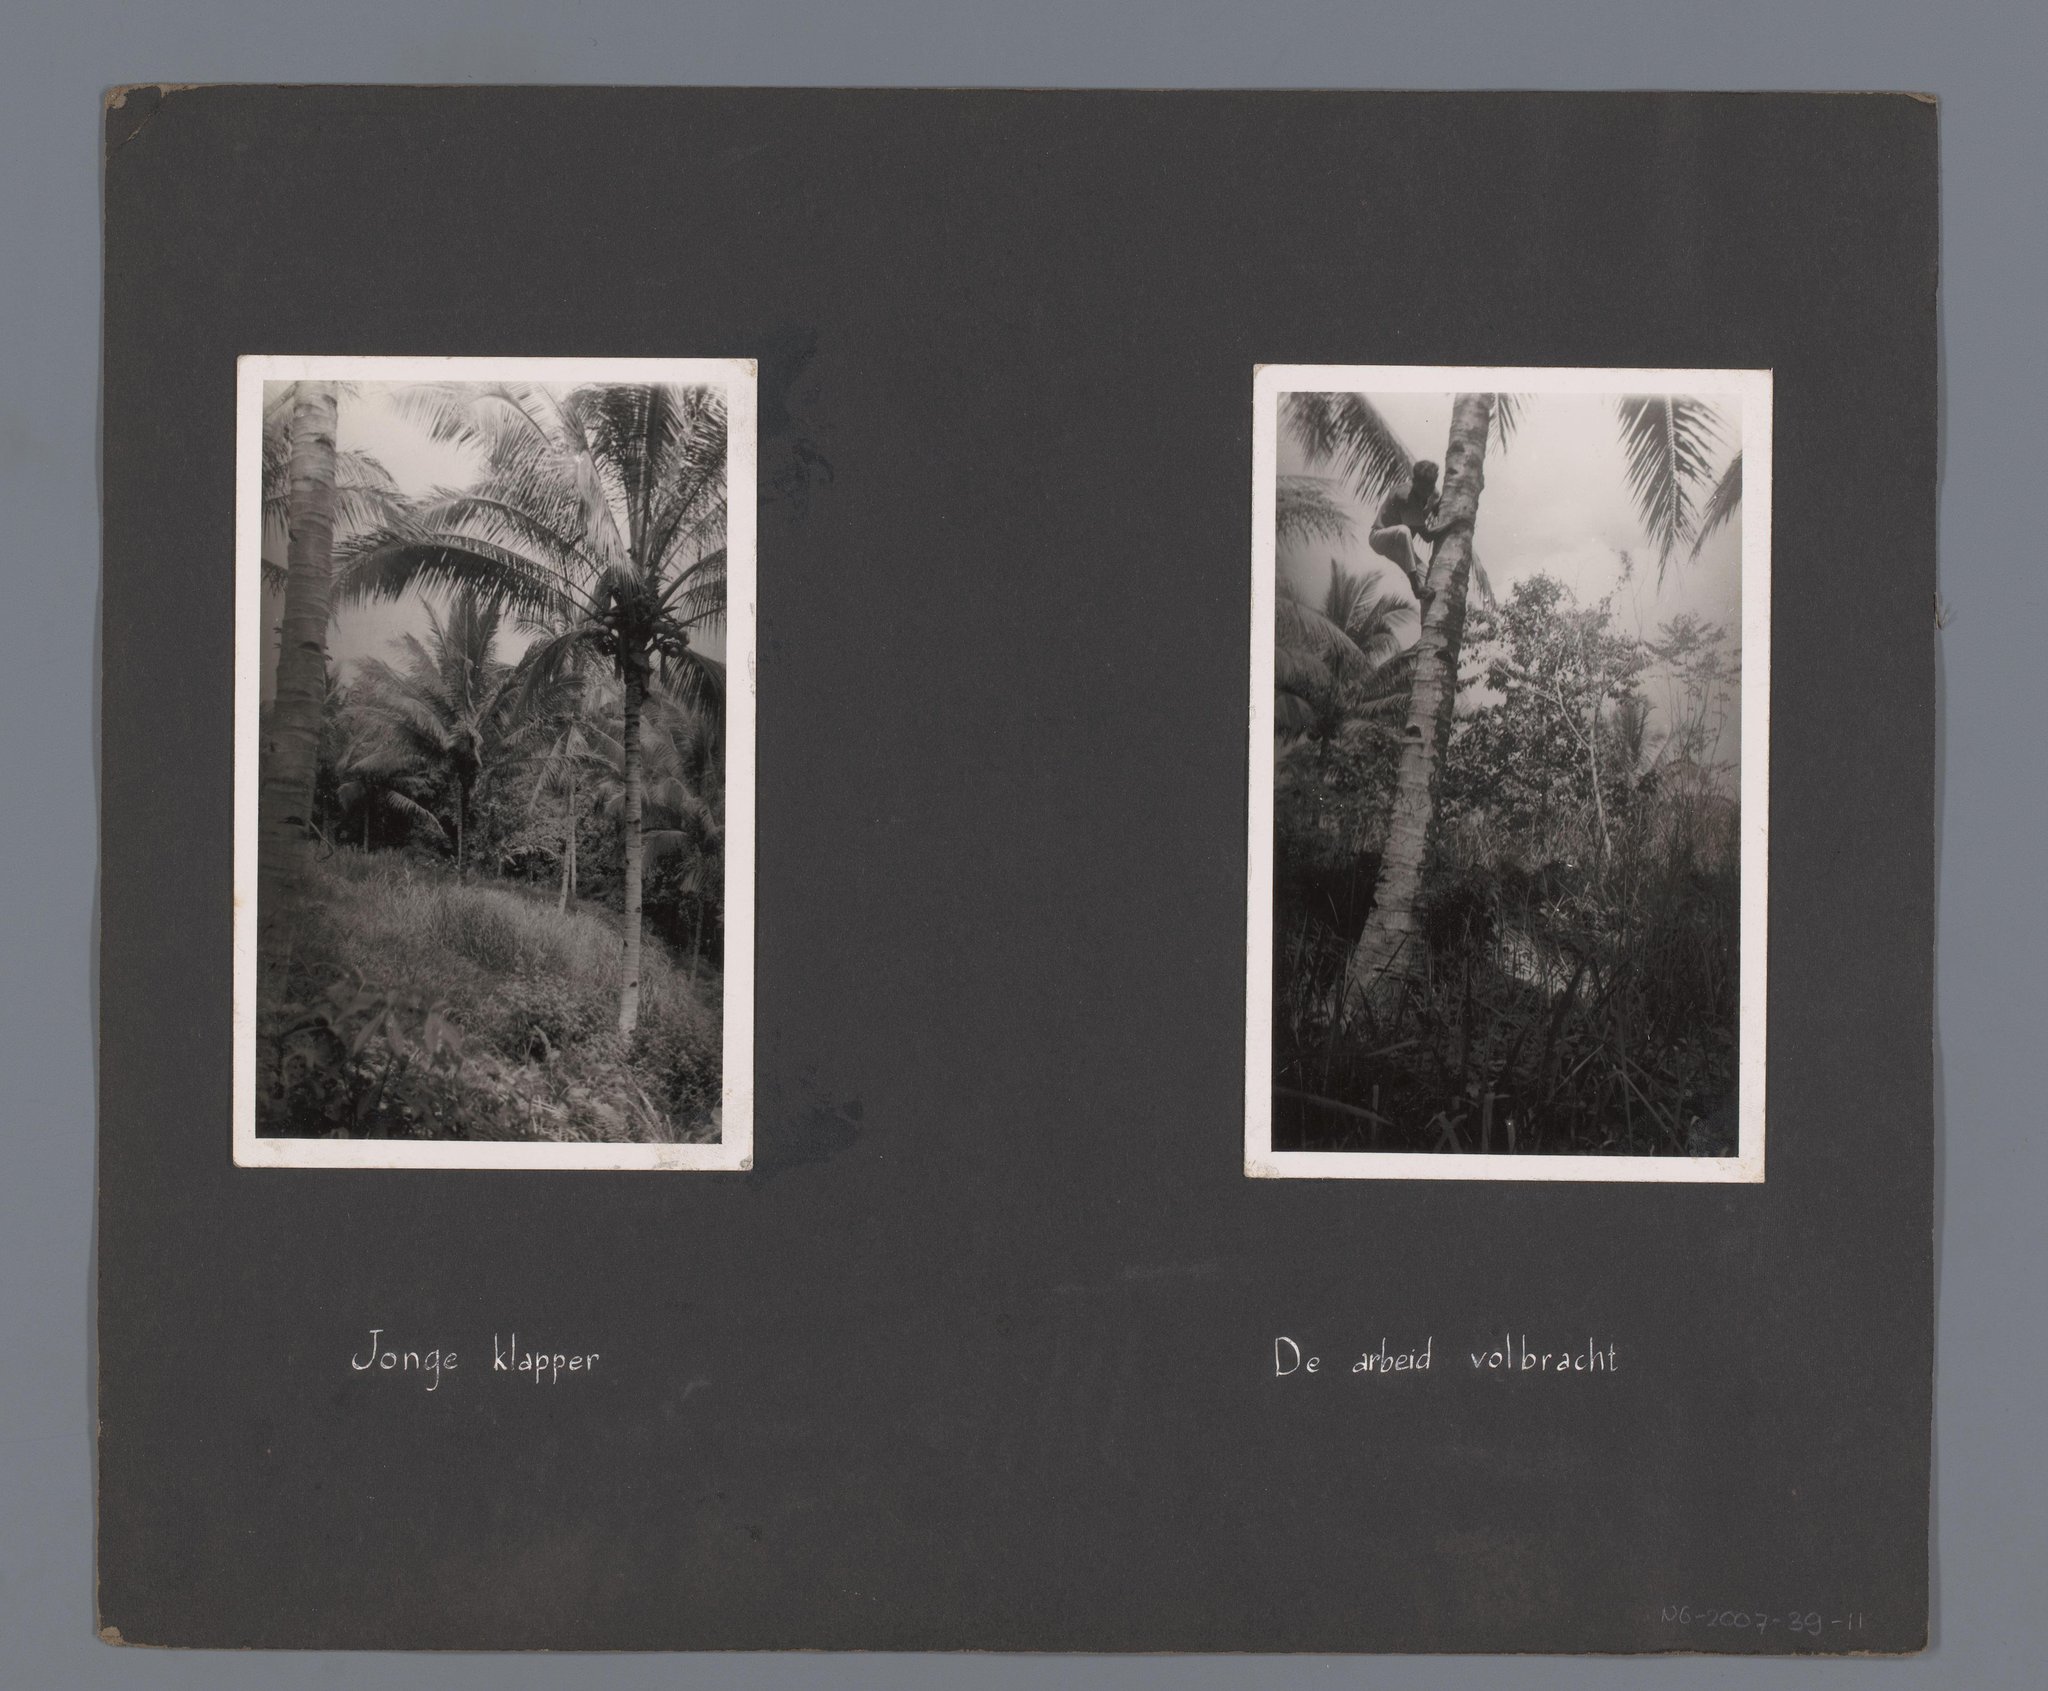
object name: album leaf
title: Jonge klapper / De arbeid volbracht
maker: Anonymous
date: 1930-1939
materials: paper, photographic support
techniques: gelatin silver print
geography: celebes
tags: plantation, trees: coconut-tree, dutch east indies, the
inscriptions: annotation: ‘Jonge klapper / De arbeid volbracht’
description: Zwart albumblad met twee foto's van kokosbomen, op de rechter foto klimt een man uit de boom. Productie van kopra. Onderdeeel van het losbladig fotoalbum over de Fraters van Tilburg op Celebes en Sumatra.